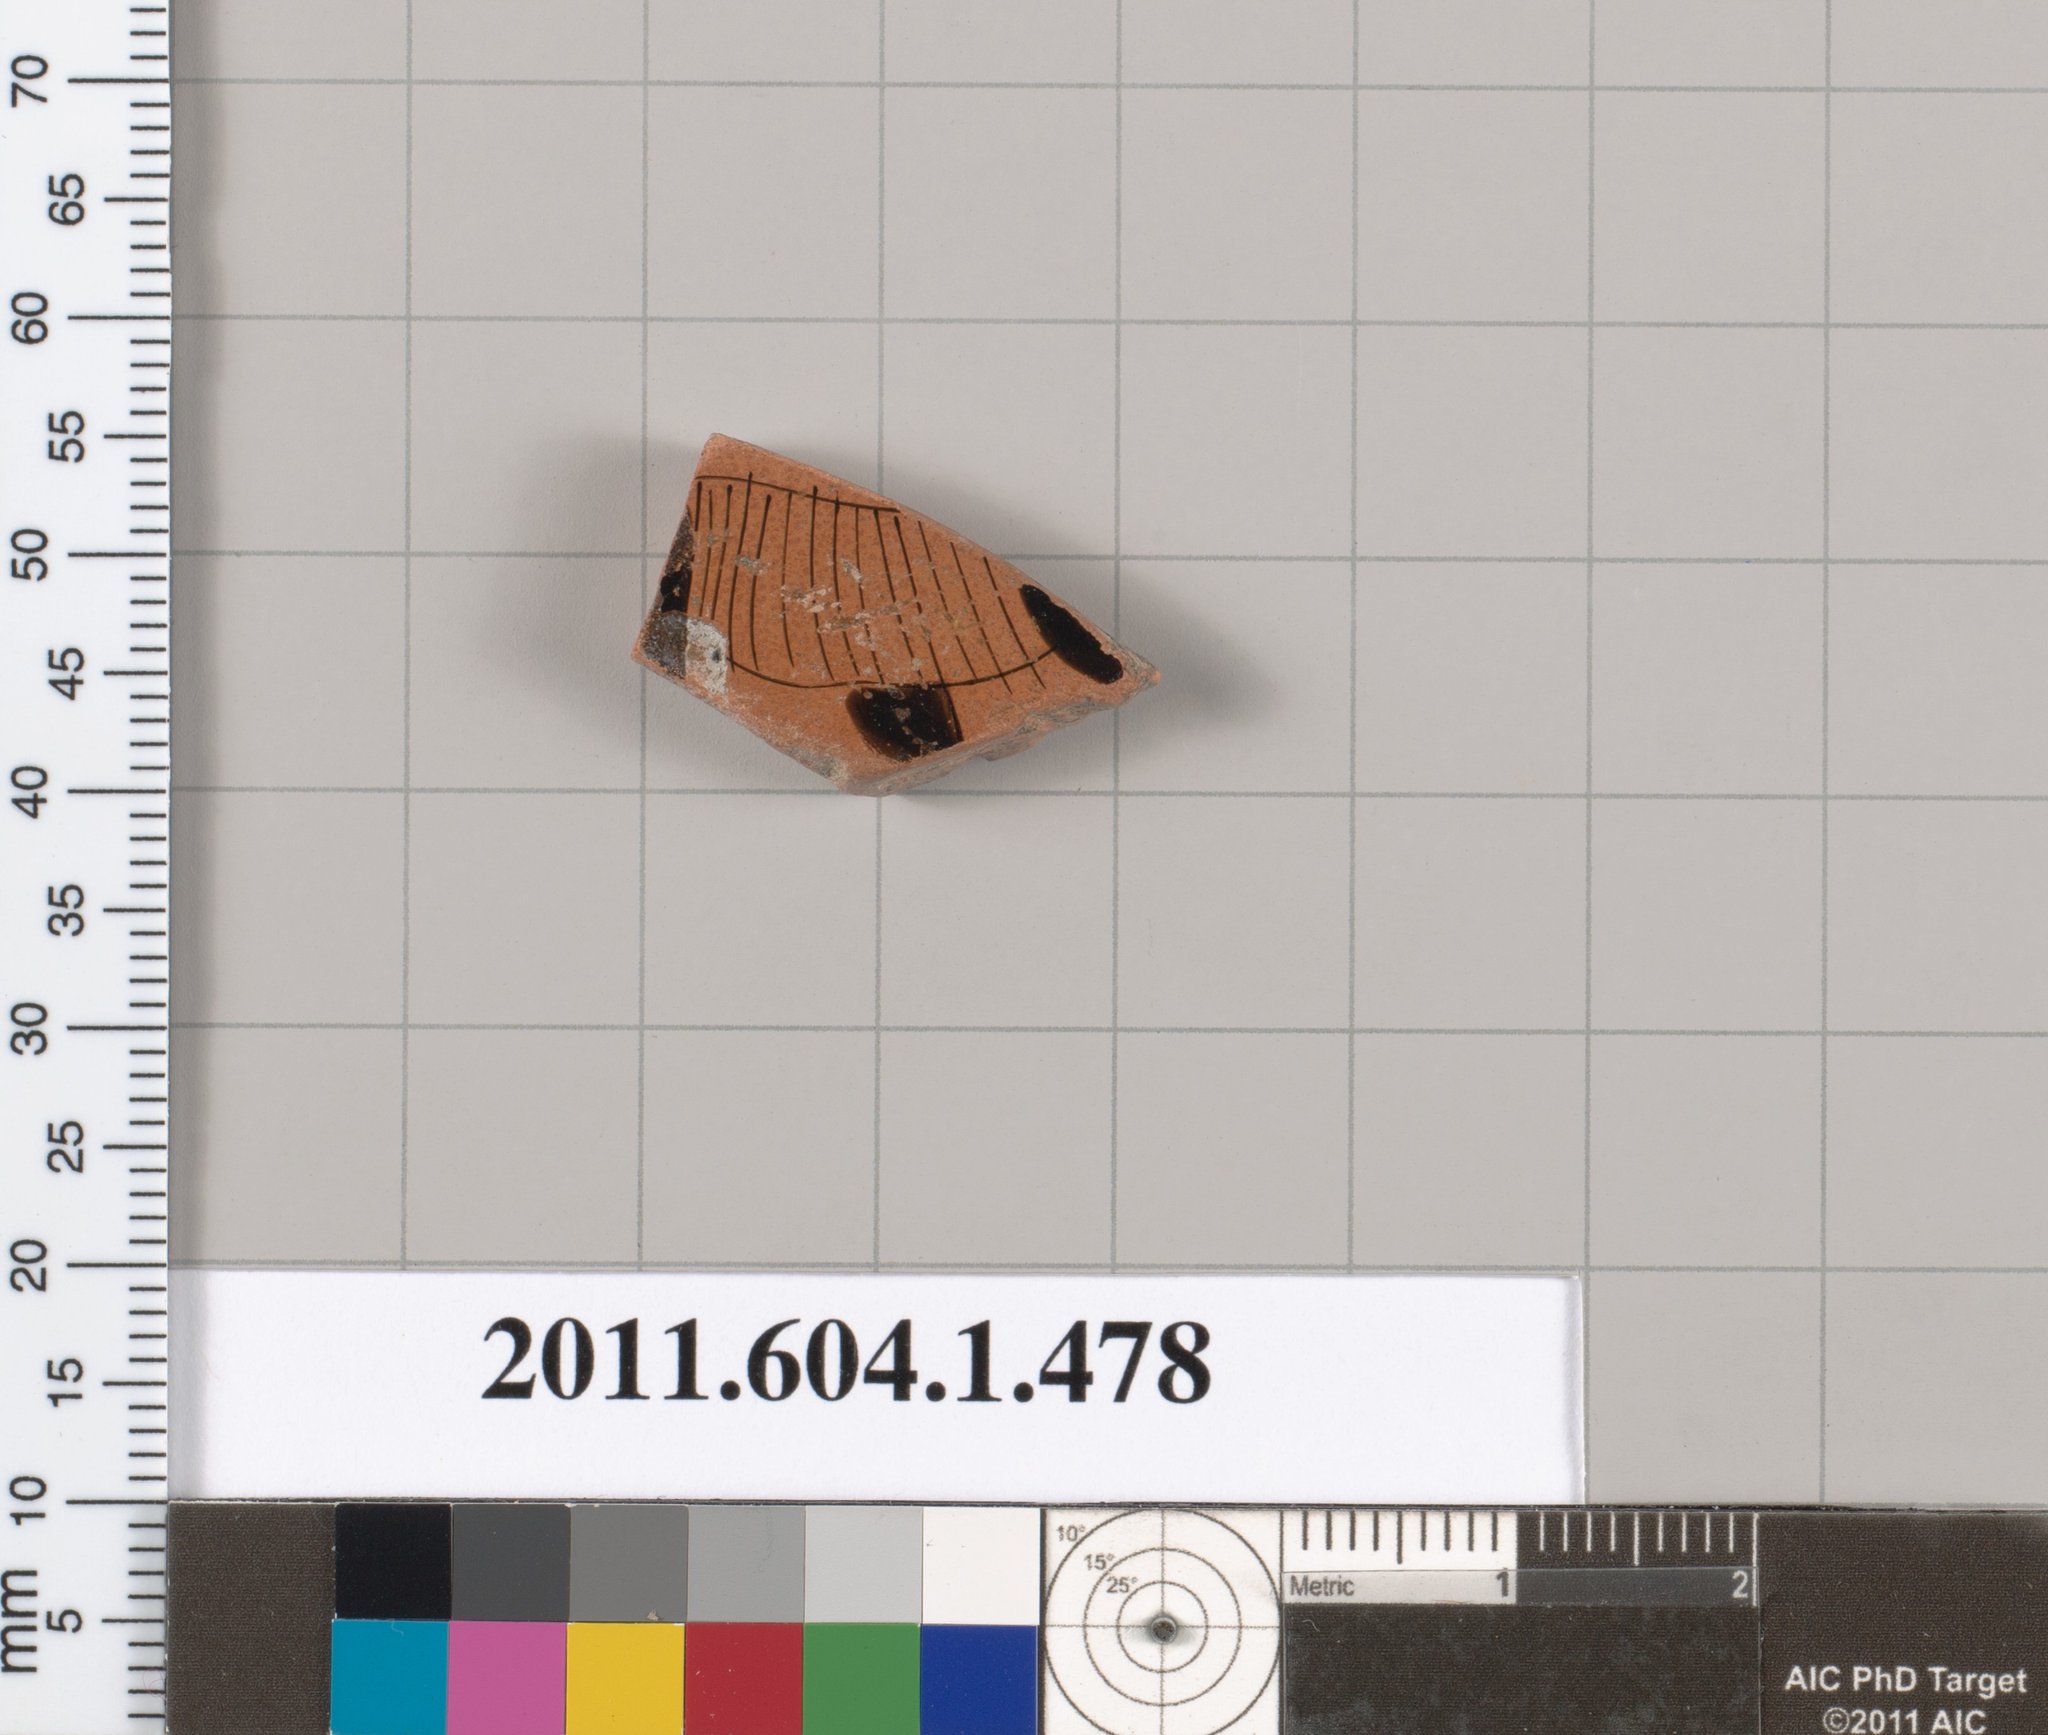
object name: kylix fragment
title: Terracotta fragment of a kylix (drinking cup)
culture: greek, attic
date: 490-480 BCE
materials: terracotta